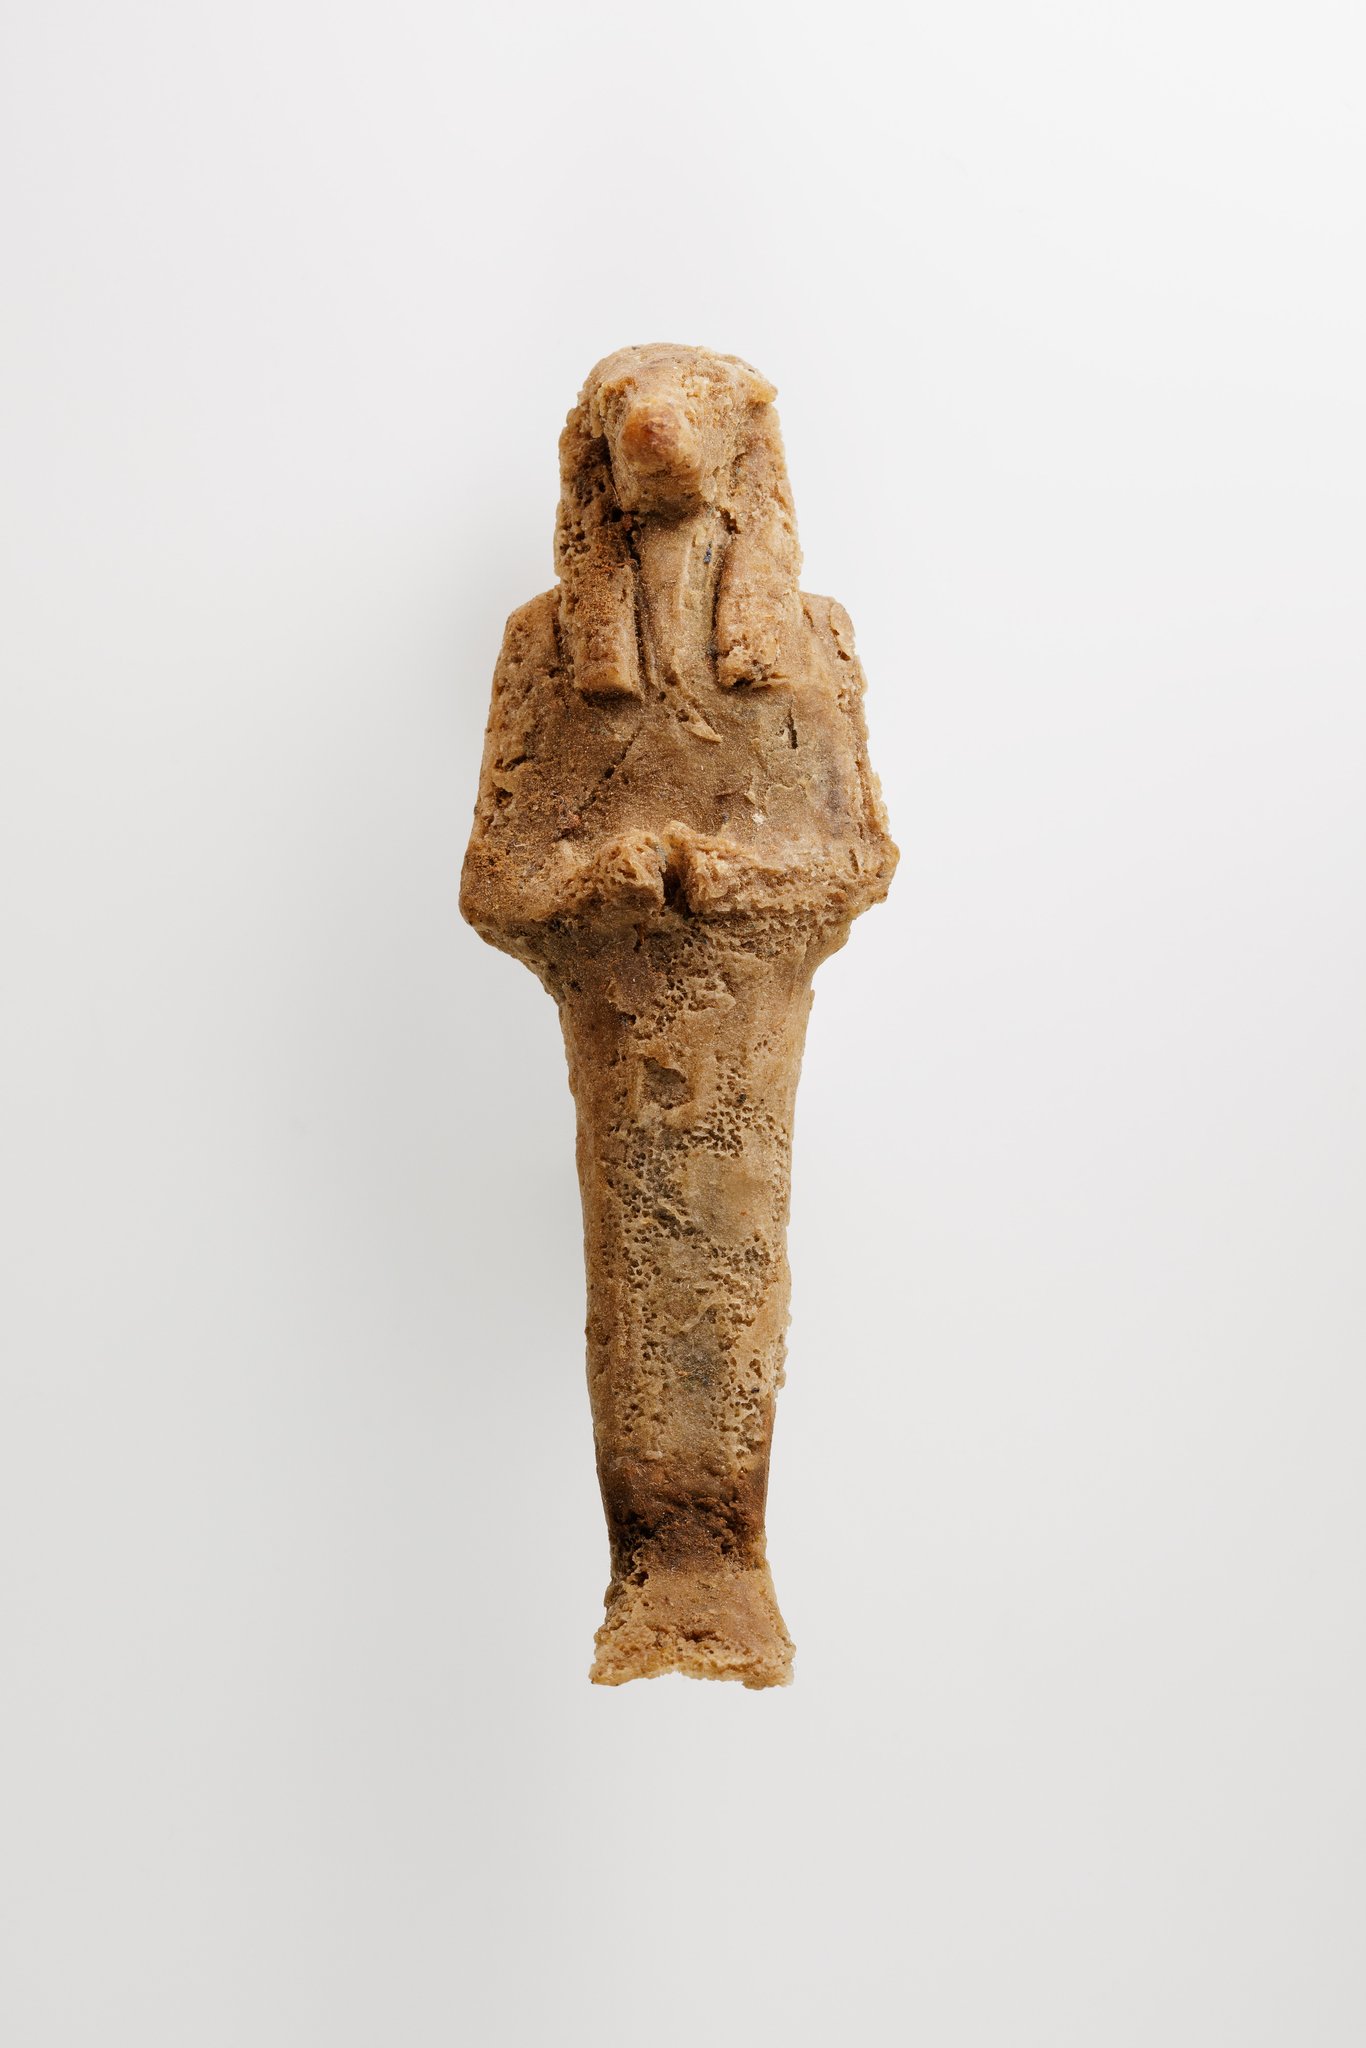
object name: four son of horus, duamutef, jackel headed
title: Viscera figure with jackal head (Duamutef)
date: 1000-945 BCE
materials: mud, wax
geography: egypt